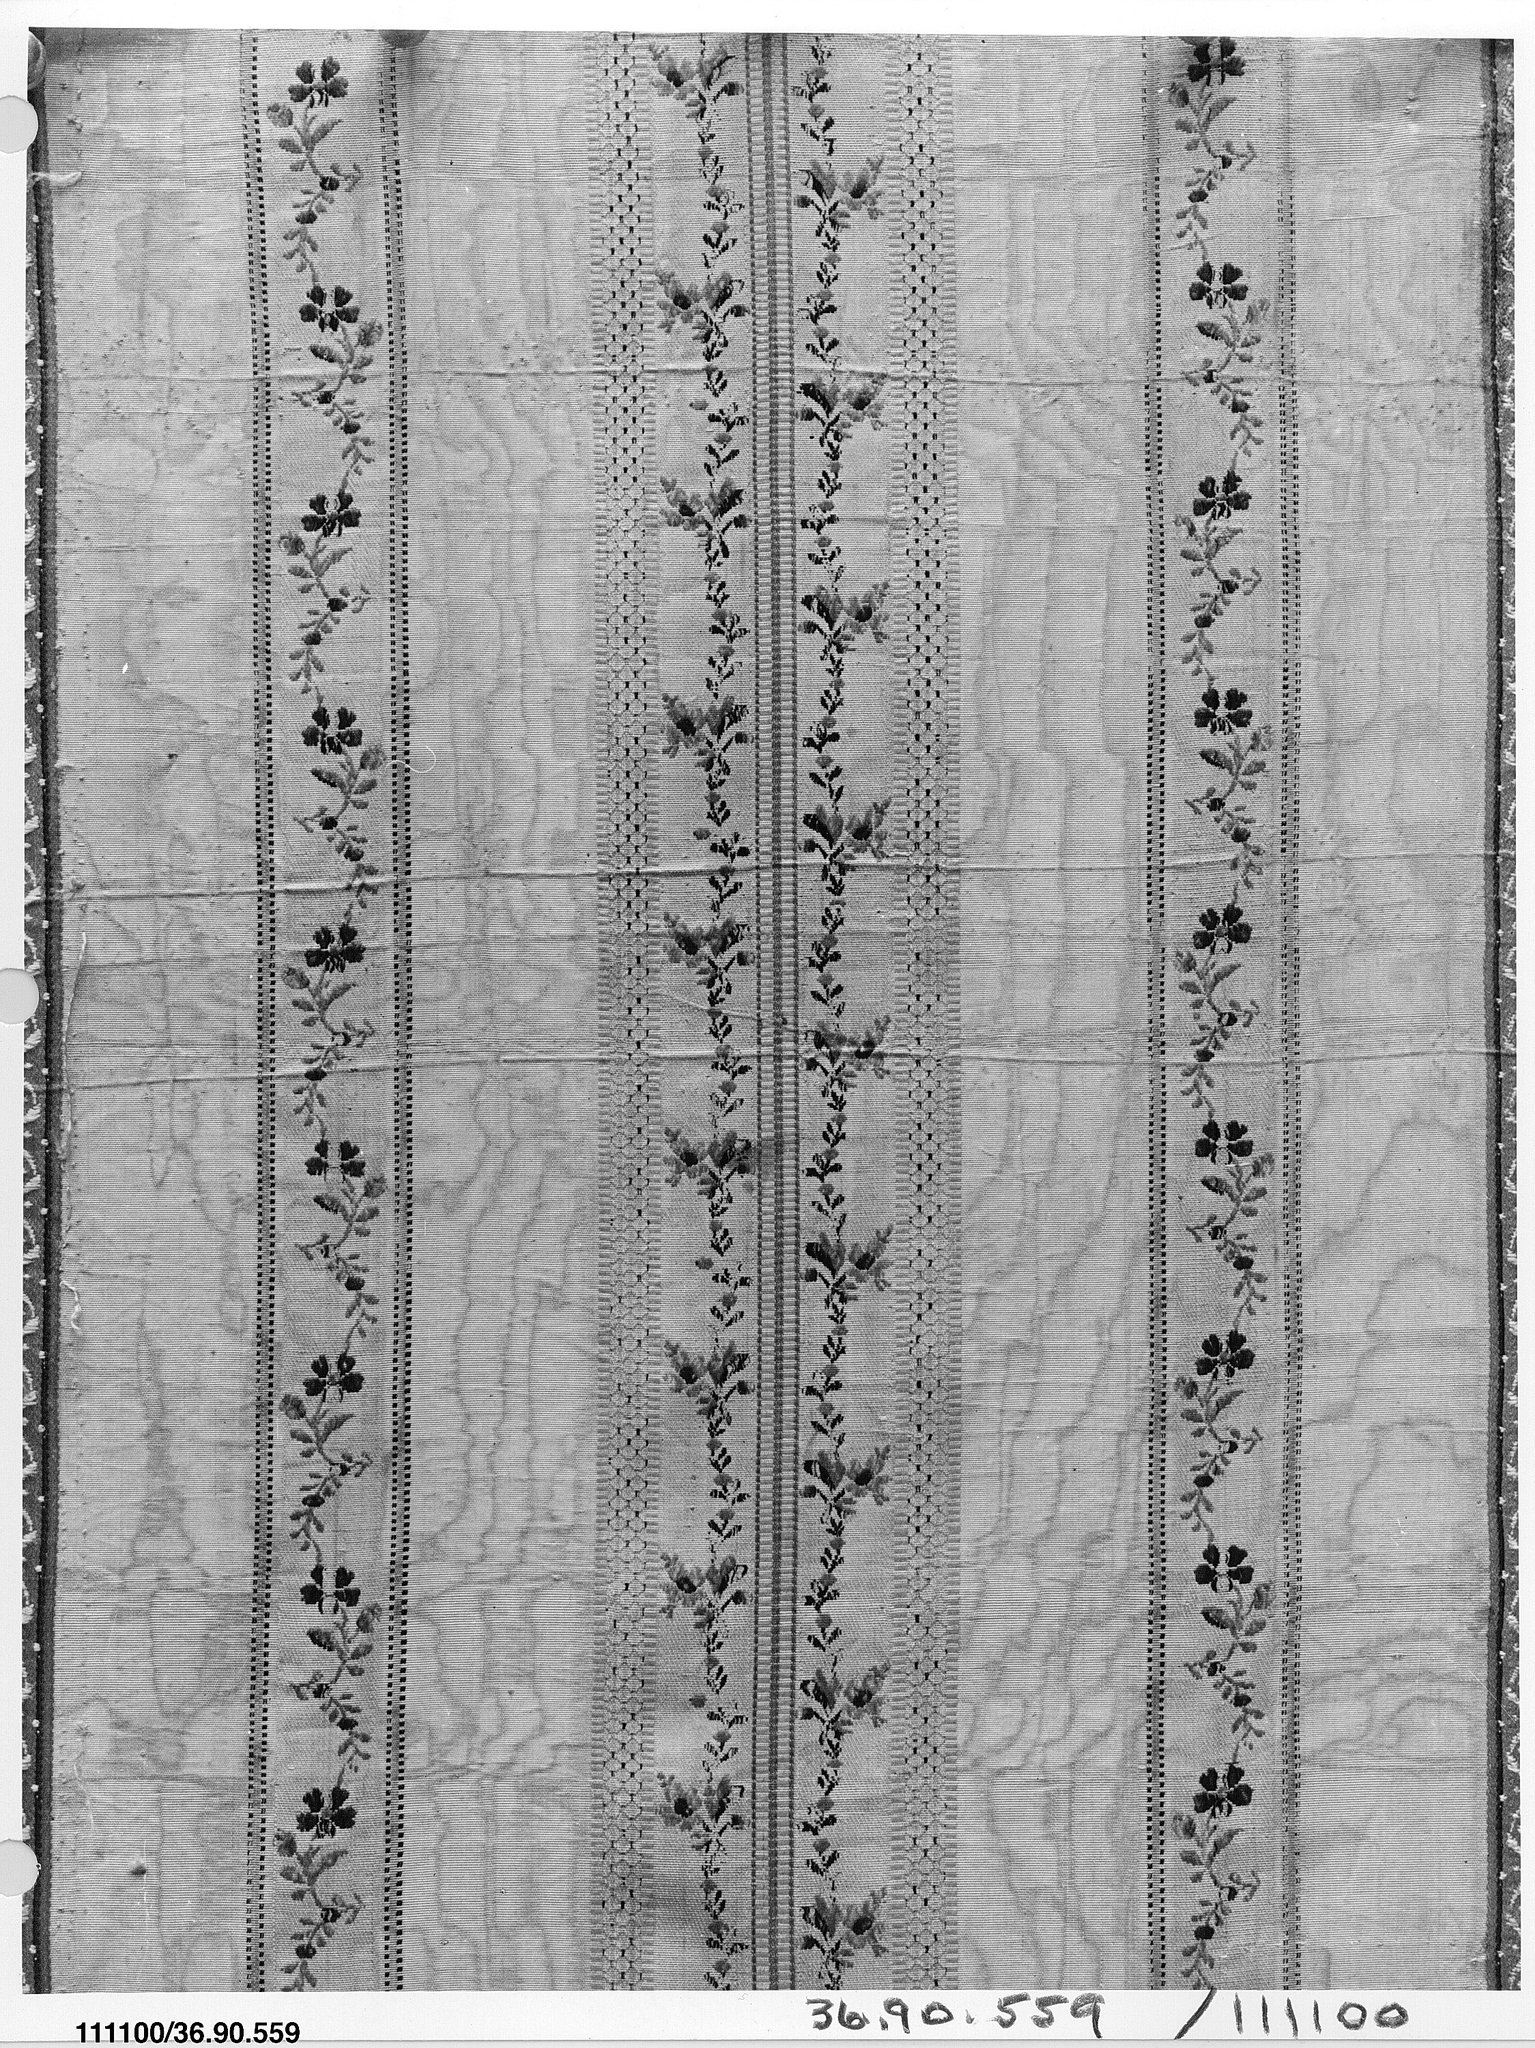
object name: piece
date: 1767-1800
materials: silk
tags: flowers